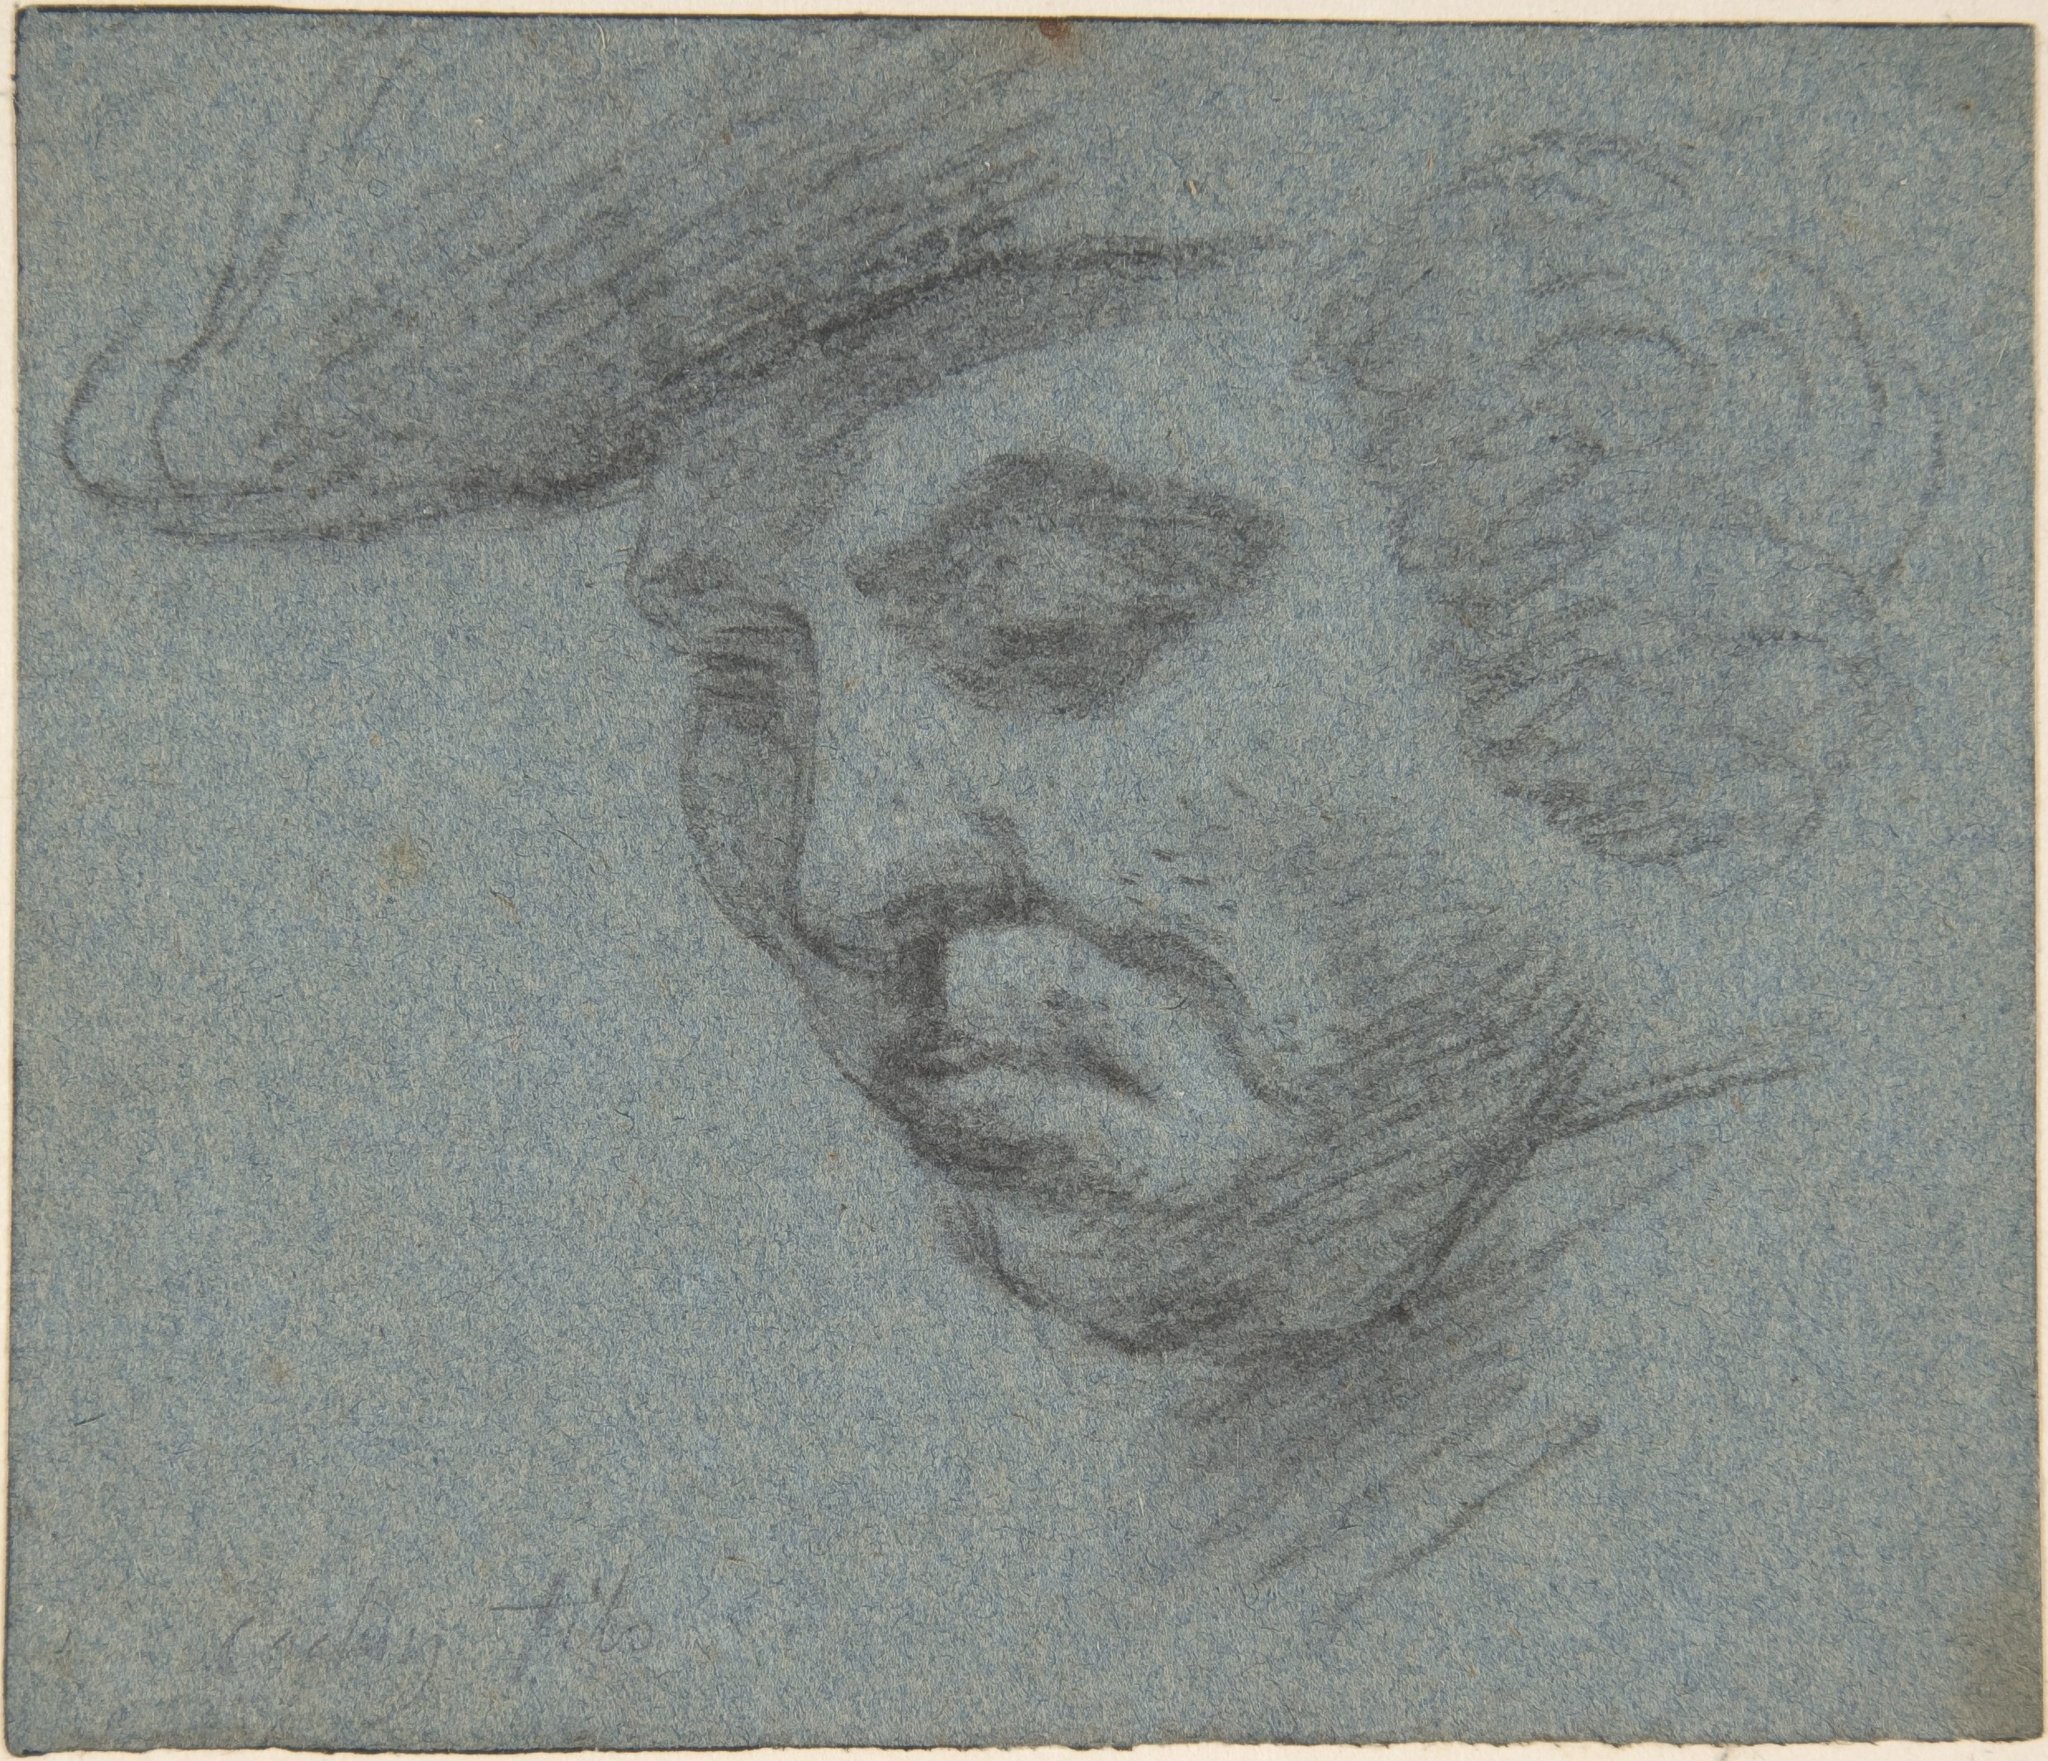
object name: drawing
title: Head of Man Facing Left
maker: charles nicolas cochin ii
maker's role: artist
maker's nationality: french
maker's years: 1715-1790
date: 1730-1790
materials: chalk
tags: heads,men,portraits